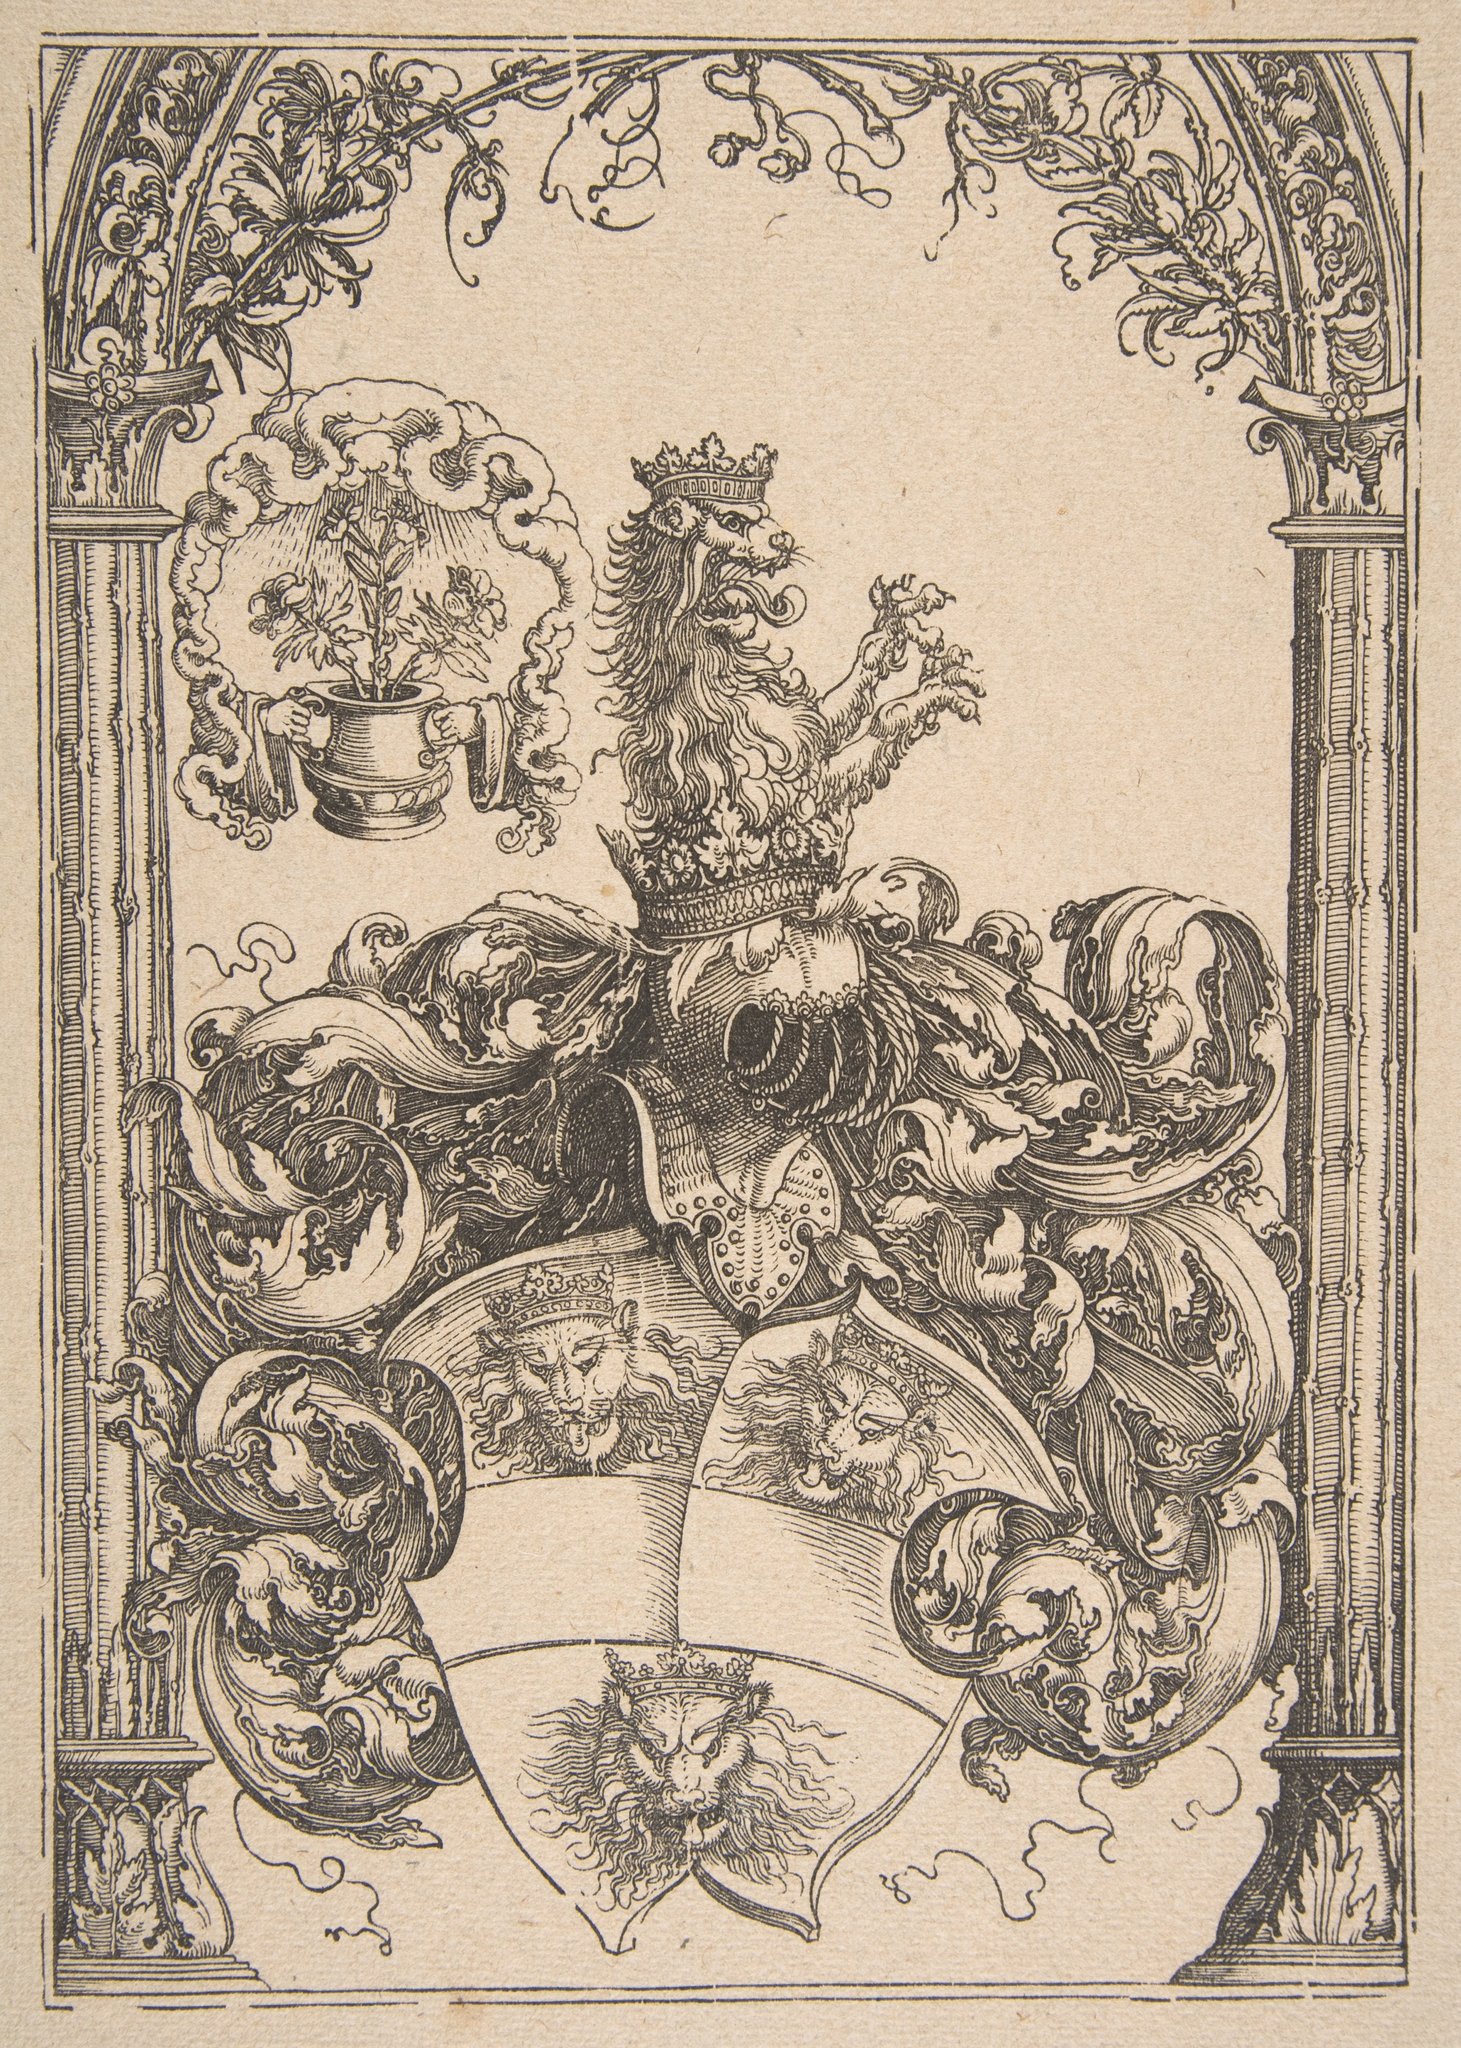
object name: print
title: Coat of arms with Three Lions' Heads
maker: albrecht dürer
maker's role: artist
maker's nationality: german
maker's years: 1471-1528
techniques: woodcut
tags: lions,coat of arms